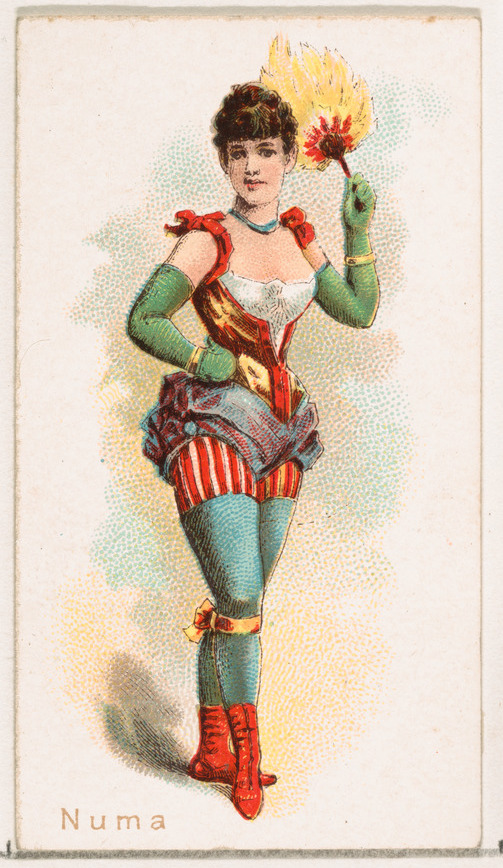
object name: print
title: Numa, from the Ballet Queens series (N182) issued by Wm. S. Kimball & Co.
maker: william s. kimball & company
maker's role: publisher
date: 1889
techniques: color lithograph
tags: women